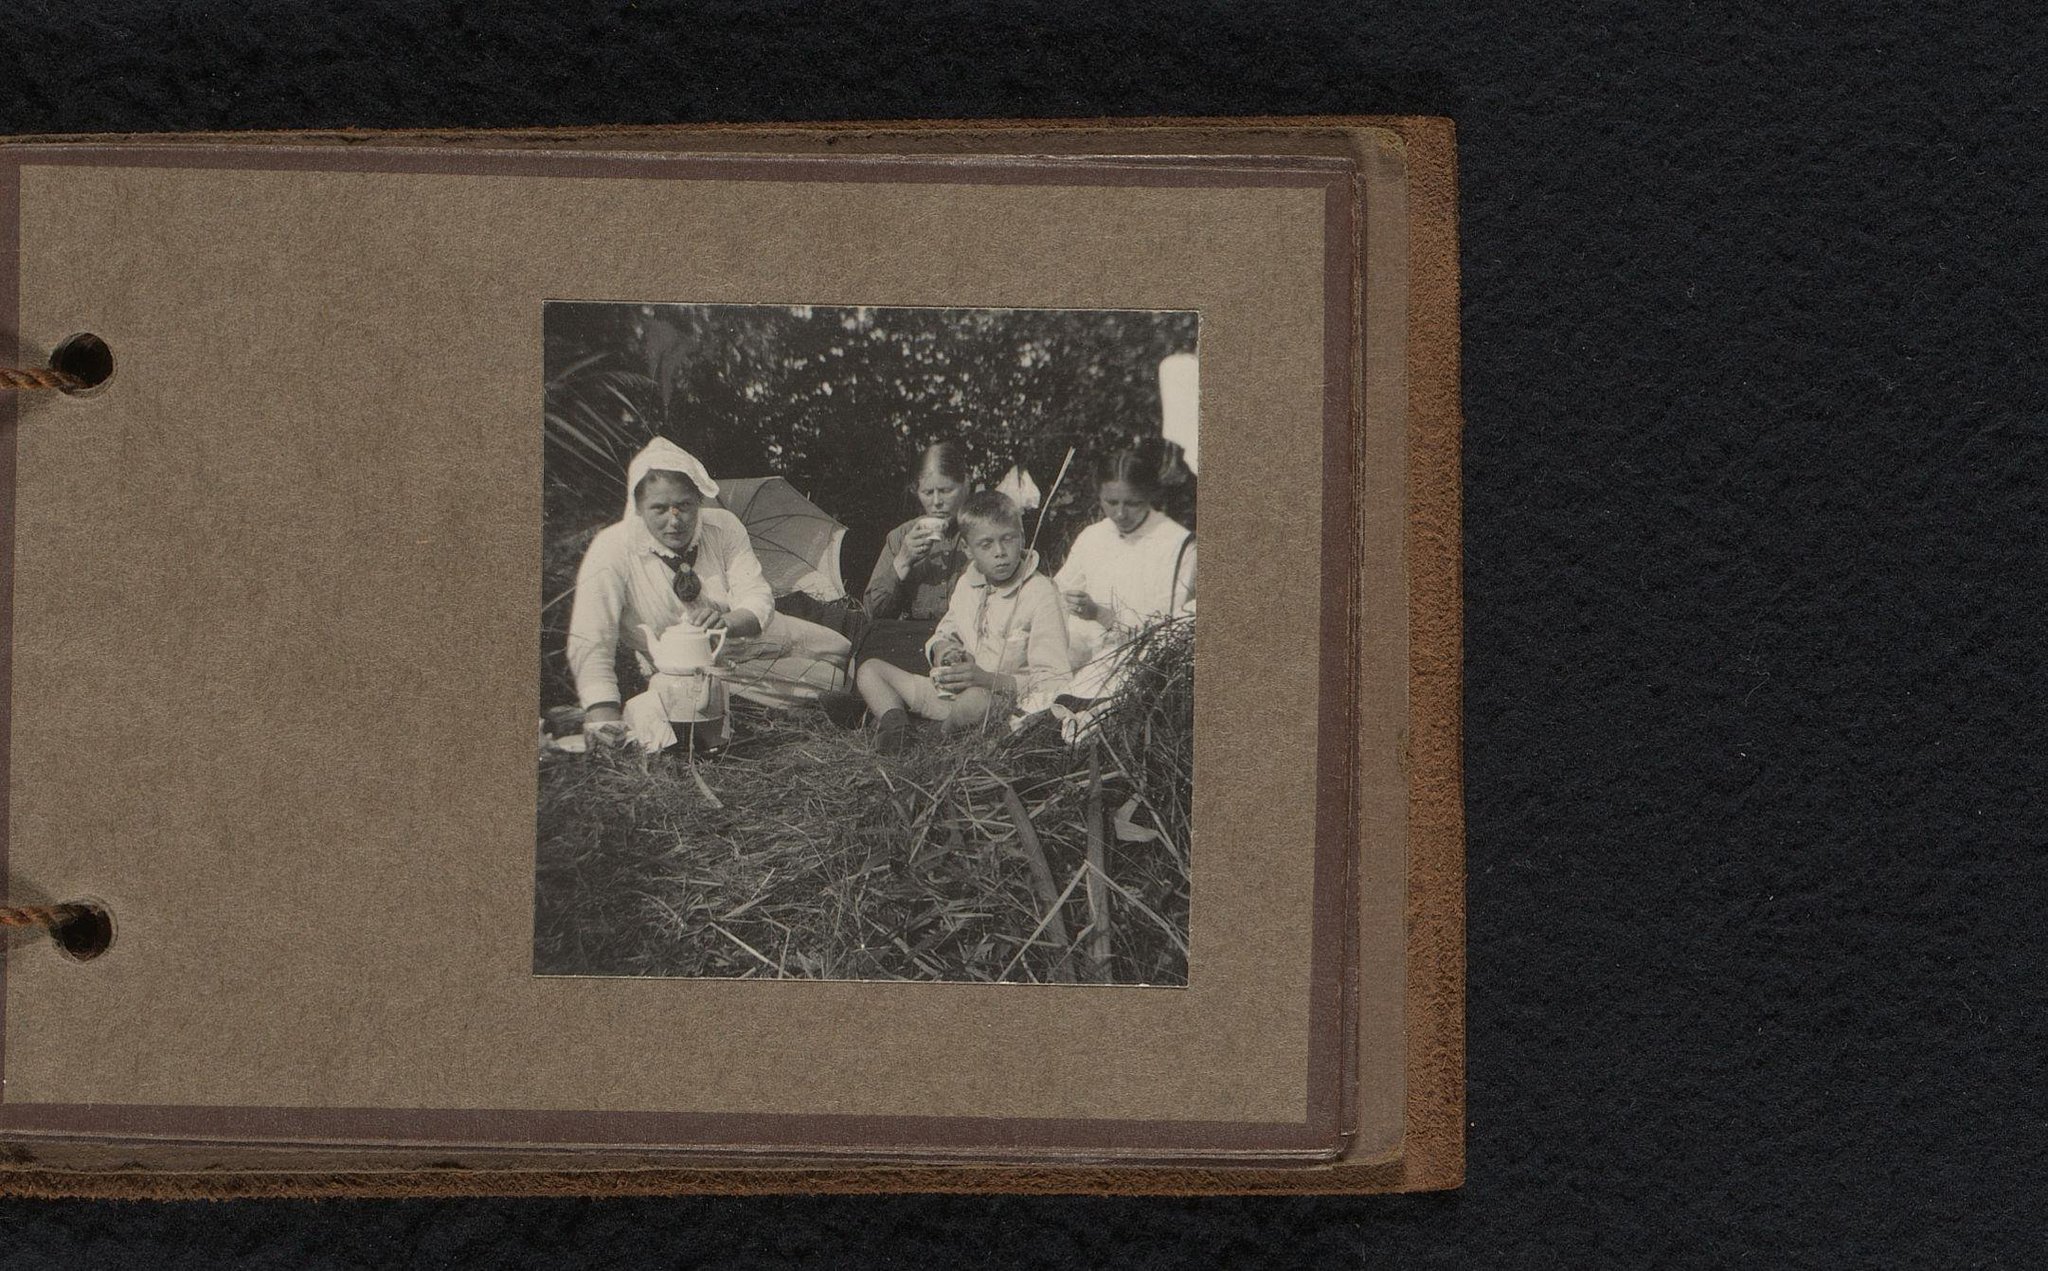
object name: photograph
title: Groepsportret van een familie met thee in het gras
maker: Anonymous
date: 1900-1930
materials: paper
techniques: gelatin silver print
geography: netherlands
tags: high tea - cc - out of doors, anonymous historical persons portrayed in a group, in a group-portrait